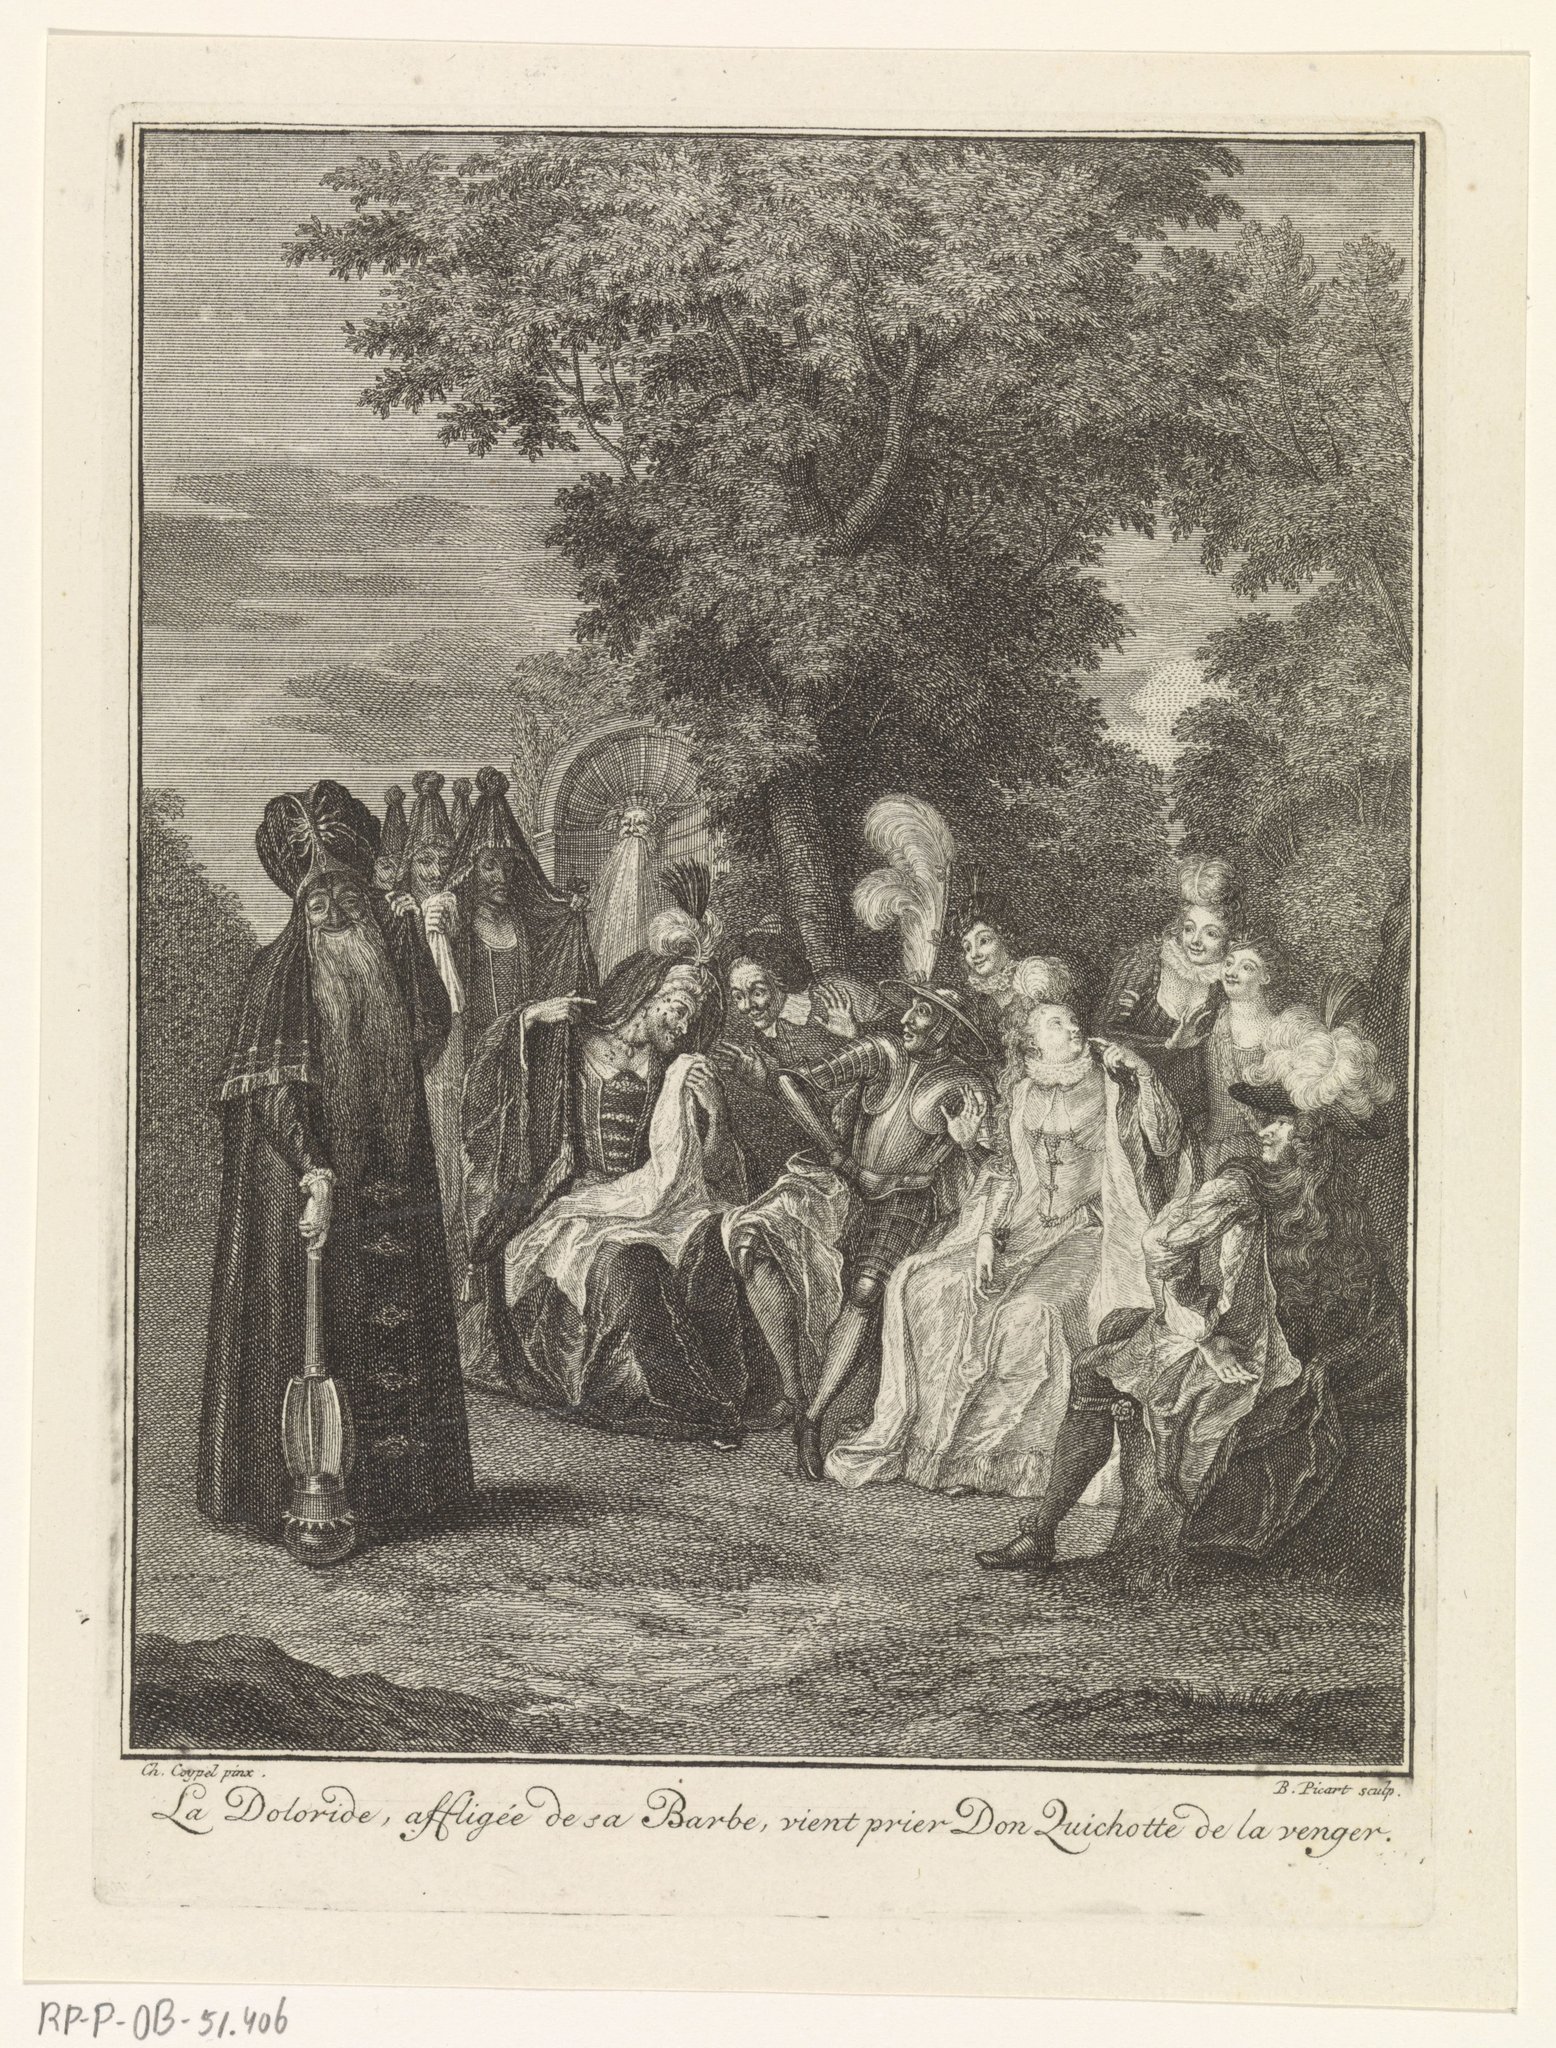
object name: book illustration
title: Don Quichot schrikt van de baard van Doloride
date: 1732-1733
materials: paper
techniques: engraving, etching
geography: amsterdam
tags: don quixote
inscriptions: collector's mark: Lugt 2228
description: Prent ook gebruikt als illustratie in: Cervantes y Saavedra, Miguel de. Les principales avantures de l'admirable Don Quichotte, repréntées en figures (...) avec les explications des XXXI planches (...) tirées de l'original espagnol de Miguel de Cervantes, tussen p. 158 en 159. [Vertaald uit het Spaans door] Jacob Campo Weyerman. Den Haag: Pieter de Hondt, 1746.